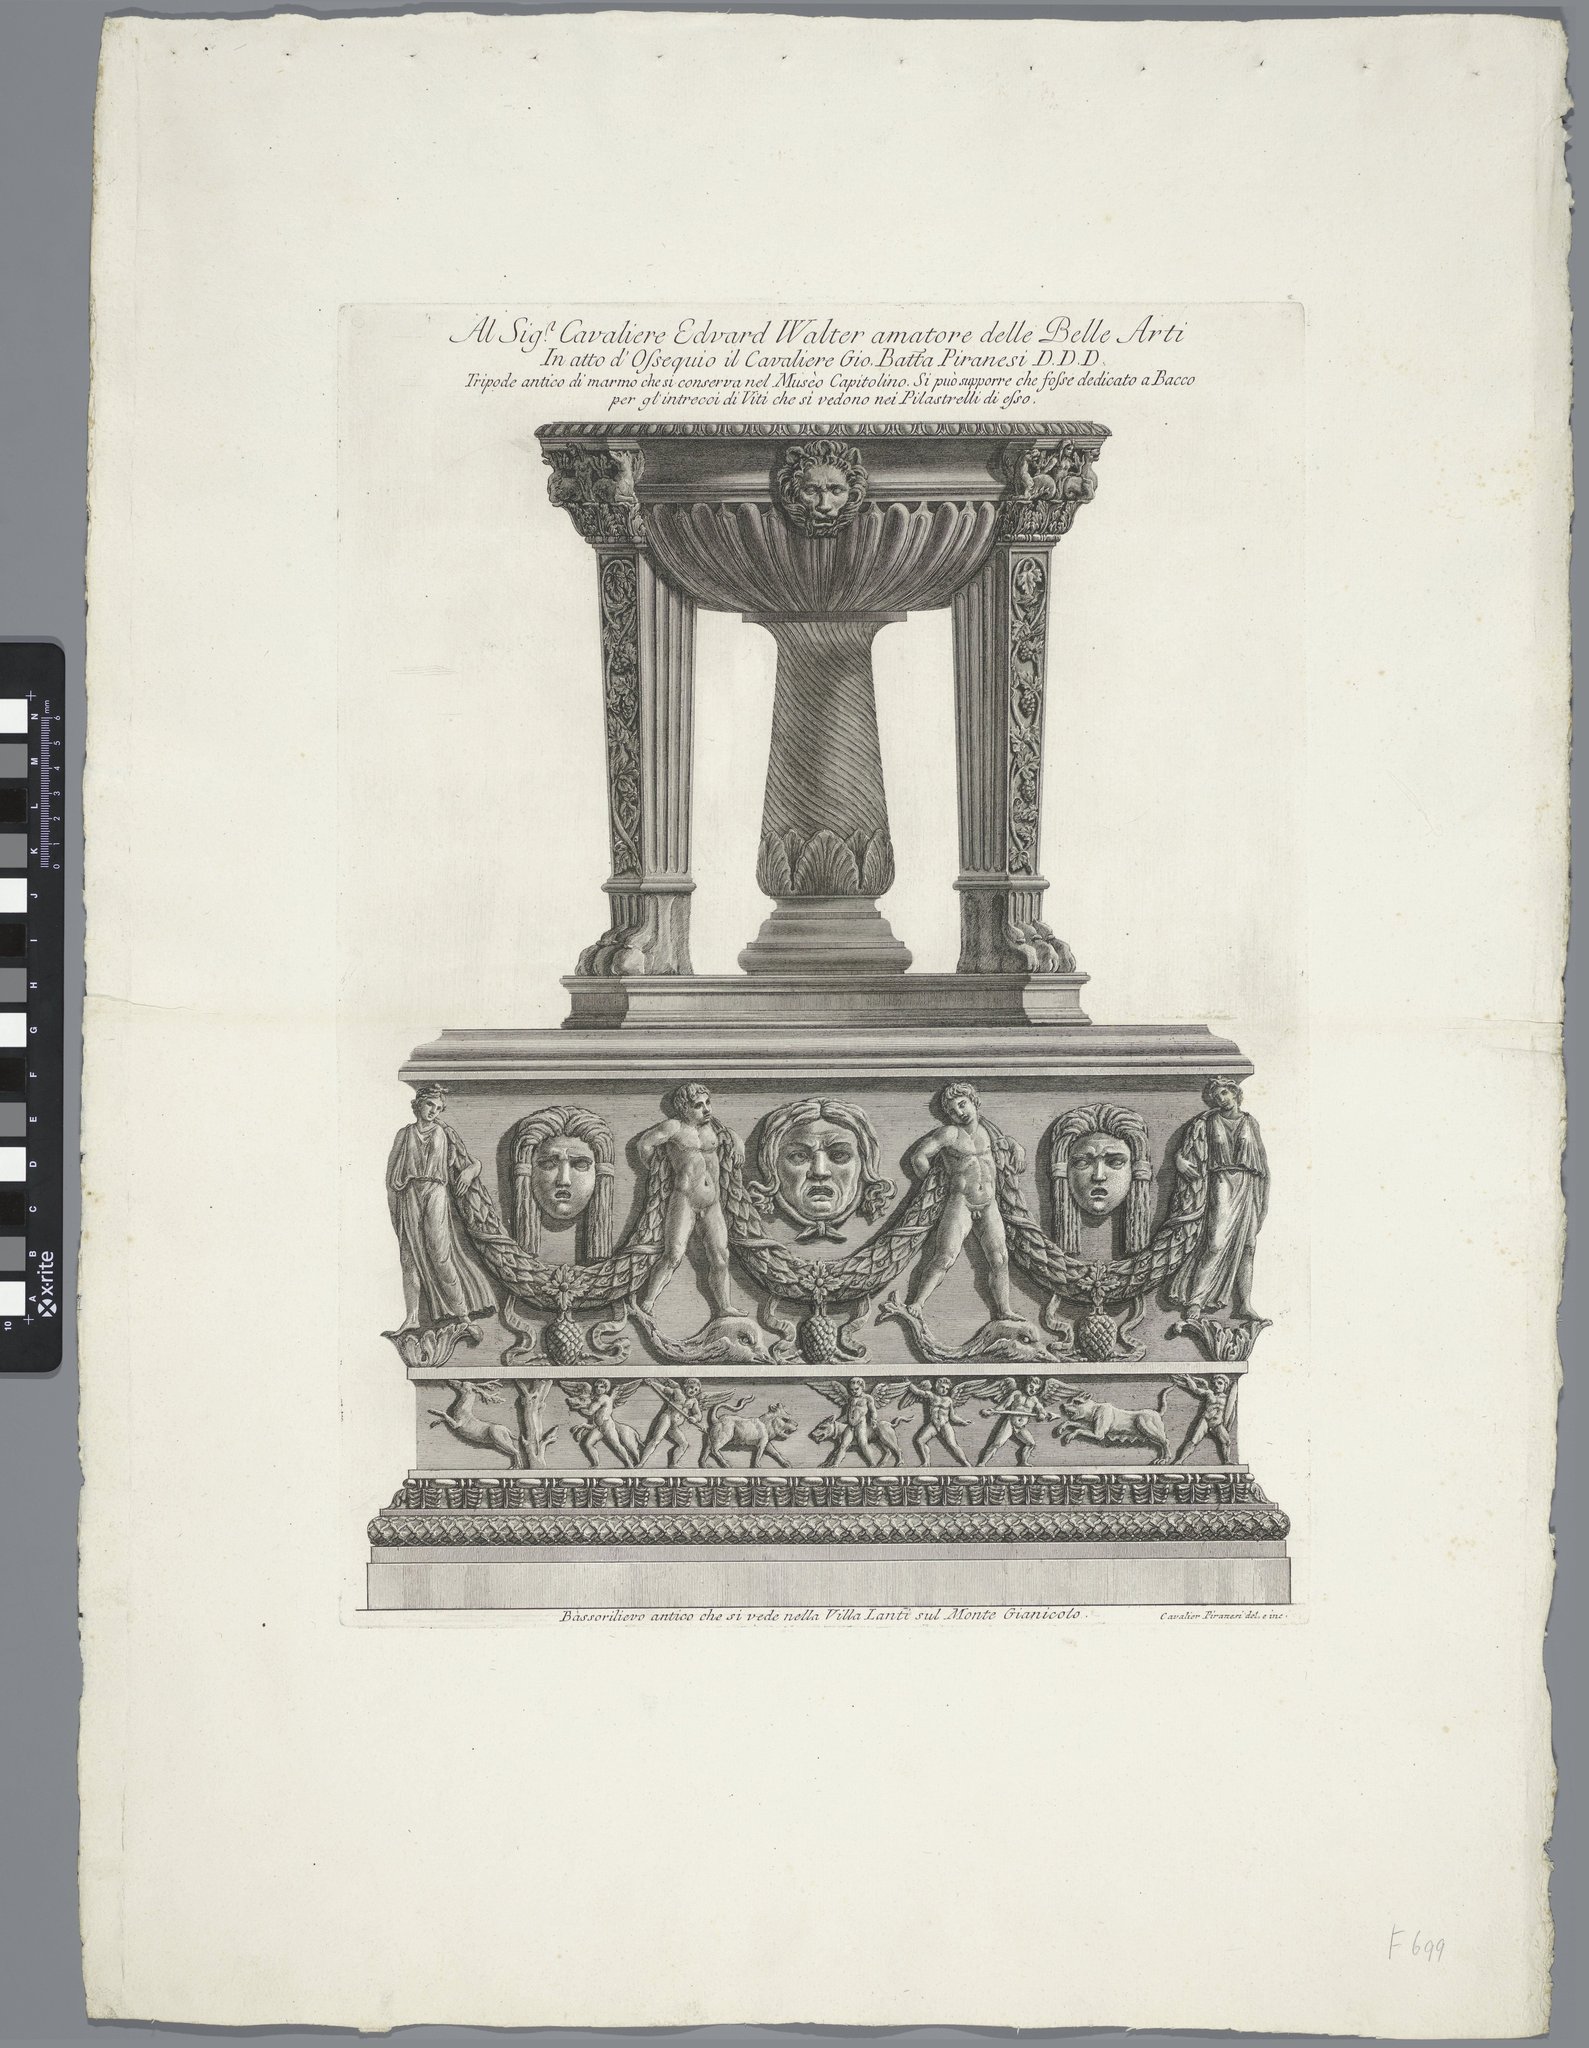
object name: print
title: Tripod op een sokkel met reliefs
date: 1778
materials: paper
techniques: etching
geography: rome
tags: tripod, ornament ~ festoon, garland, cupids: 'amores', 'amoretti', 'putti'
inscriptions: collector's mark: Lugt 2228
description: De 'Vasi'-reeks telt 110 prenten, verspreid over twee volumes met elk een eigen titelprent. Piranesi werd voor deze reeks geholpen door verschillende assistenten uit zijn werkplaats, waaronder zijn zoon Francesco die ook nog eens 8 platen toevoegde aan de reeks in 1779-1780.